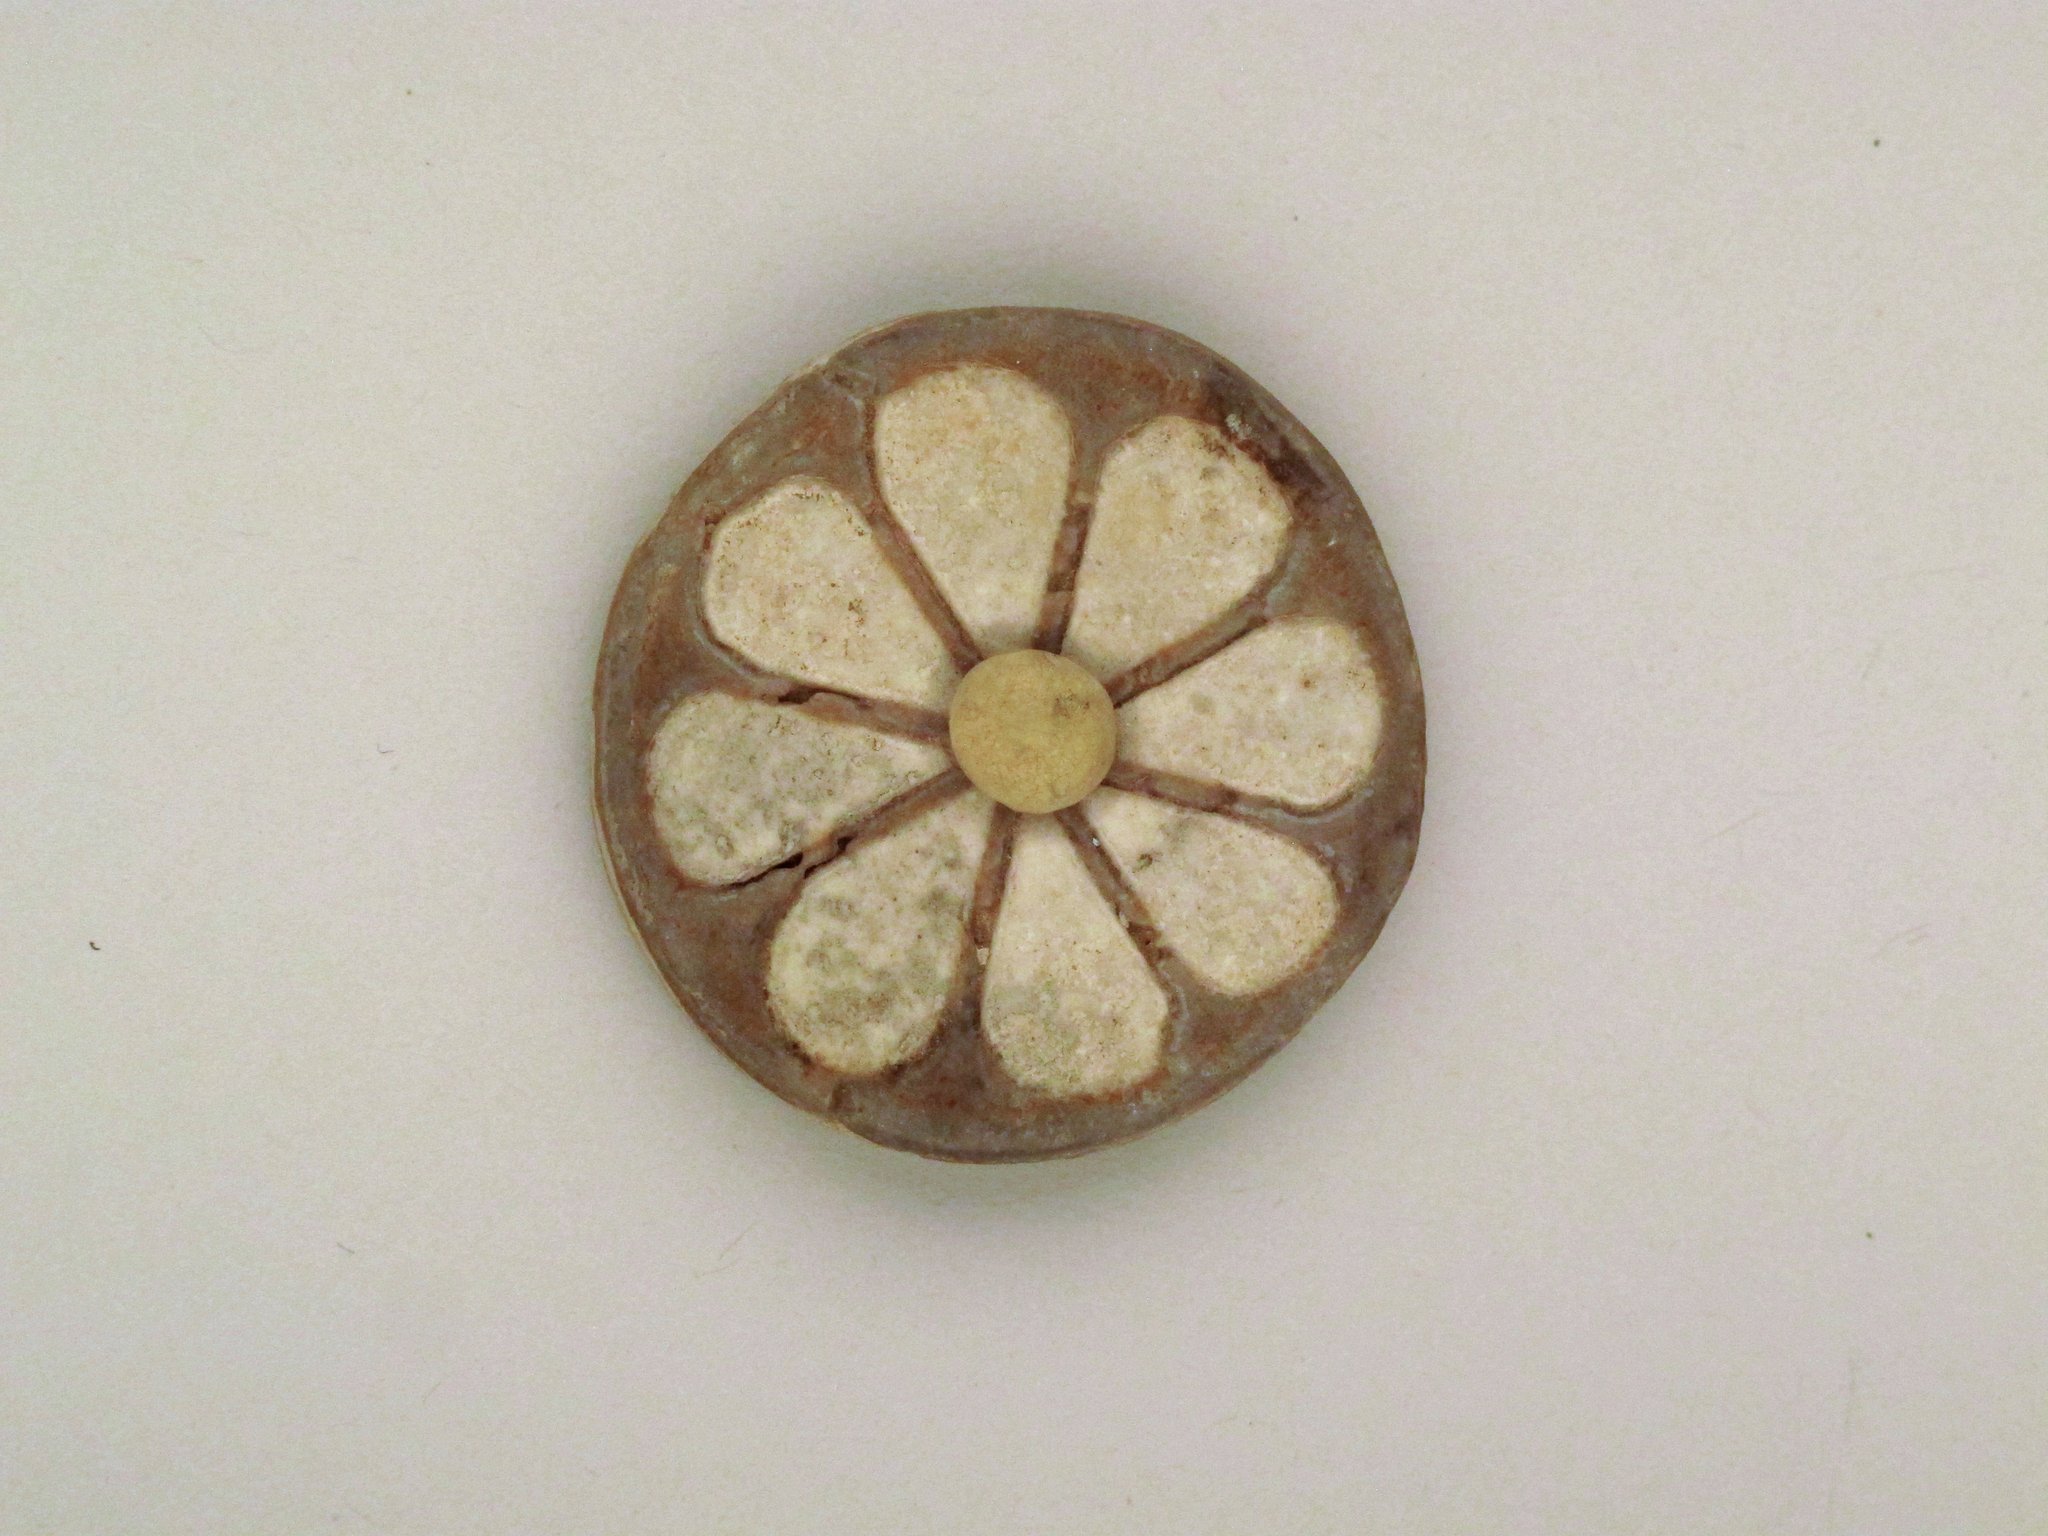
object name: roundel with daisy pattern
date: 7000 BCE-330 CE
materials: clay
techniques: glazing